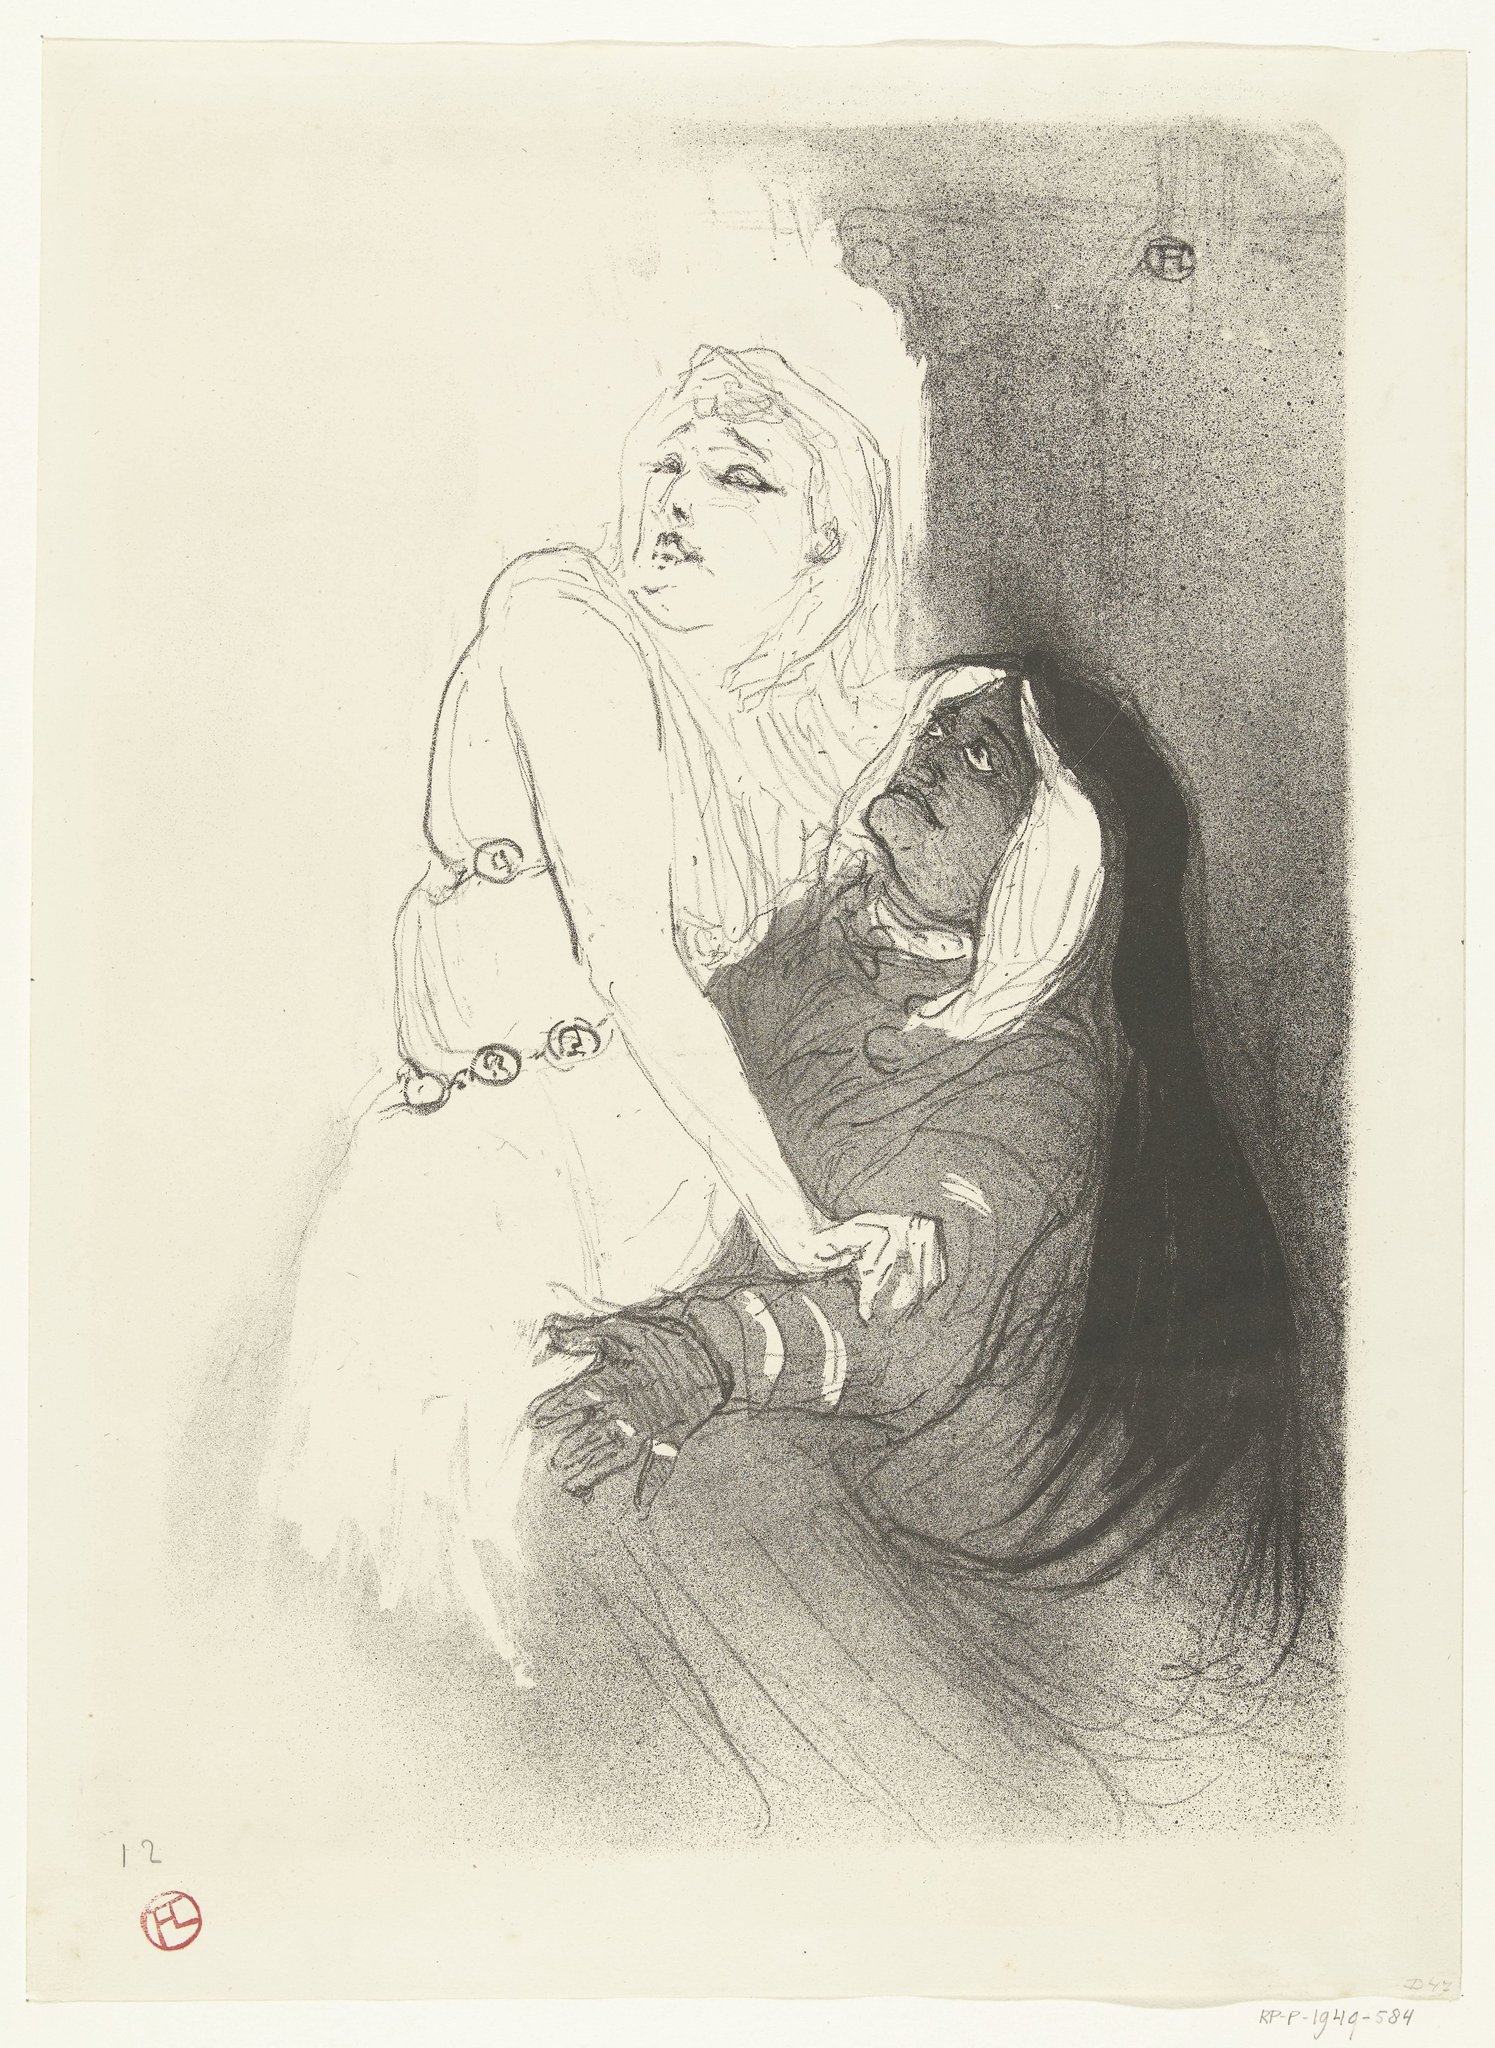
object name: print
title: A la Renaissance. Sarah Bernhardt dans Phèdre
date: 1893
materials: paper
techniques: lithograph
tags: paris, sculptor, sarah bernhardt, portrait of actor, actress, actress (on the stage)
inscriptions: stamp: Lugt 1338, collector's mark: Lugt 2228, collector's mark: Lugt 2760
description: Actrice Sarah Bernhardt in haar hoofdrol in het toneelstuk Phèdre (Phaedra). Zij lijkt zich los te maken uit een omhelzing van een man, waarschijnlijk Hippolytus of Theseus.